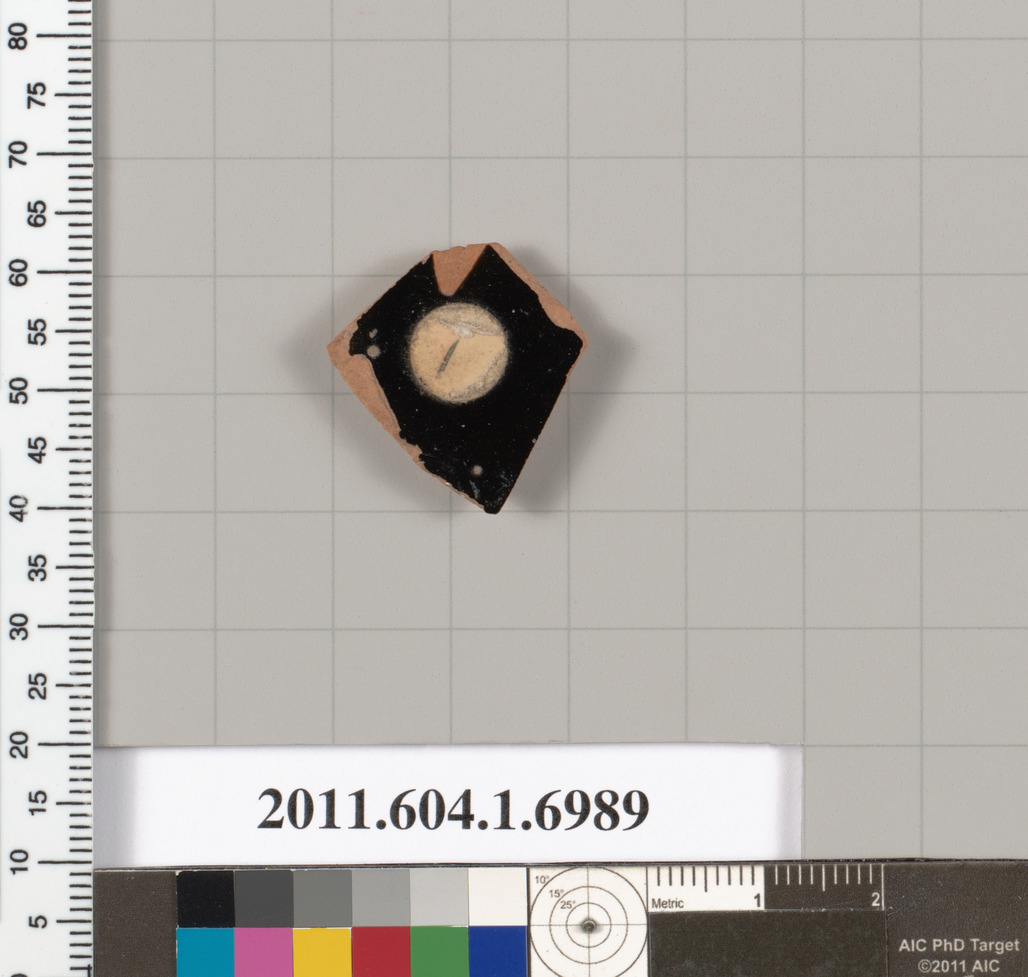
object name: kylix fragment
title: Terracotta fragment of a kylix (drinking cup)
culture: greek, attic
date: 490-470 BCE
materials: terracotta